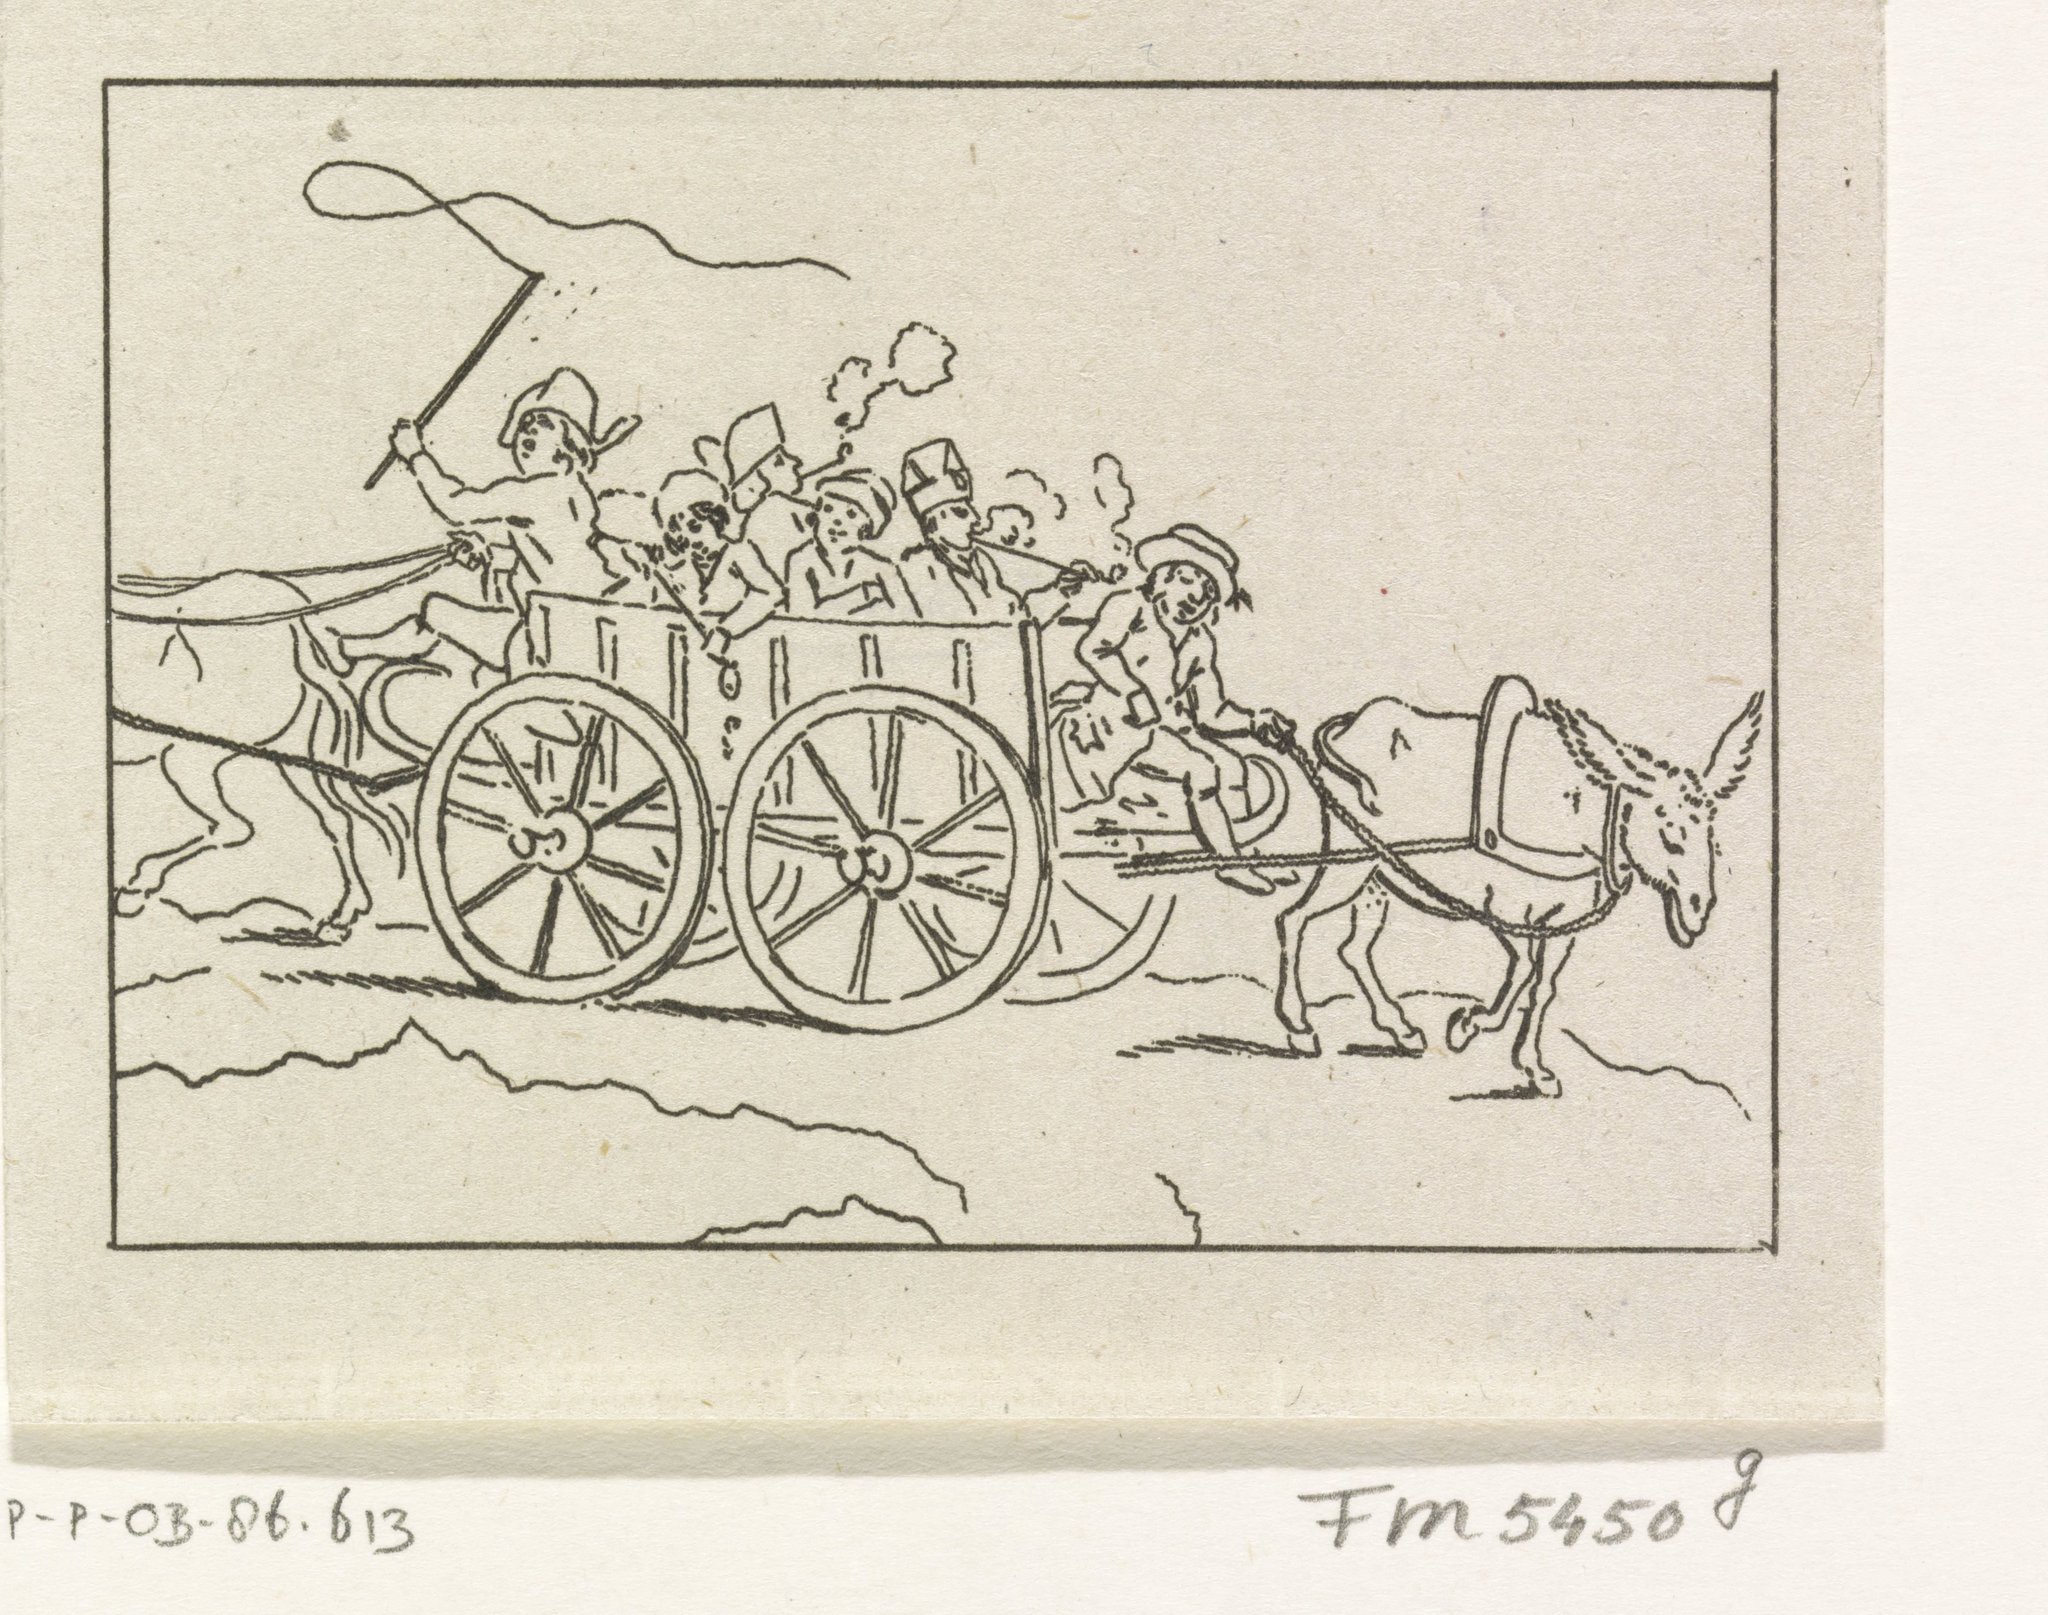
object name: book illustration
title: Wagen met twee bestuurders, 1796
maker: pieter van woensel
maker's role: print maker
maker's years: 1747-1808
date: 1795-1796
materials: paper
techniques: etching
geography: netherlands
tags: (farm) wagon, freight wagon, cart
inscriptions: collector's mark: Lugt 2228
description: Spotprent van een wagen met twee bestuurders en die aan een kant met een paard en aan de andere kant met een ezel is bespannen. Tegenover blz.160: 'Van de tegenwoordige regeeringe van Holland'.